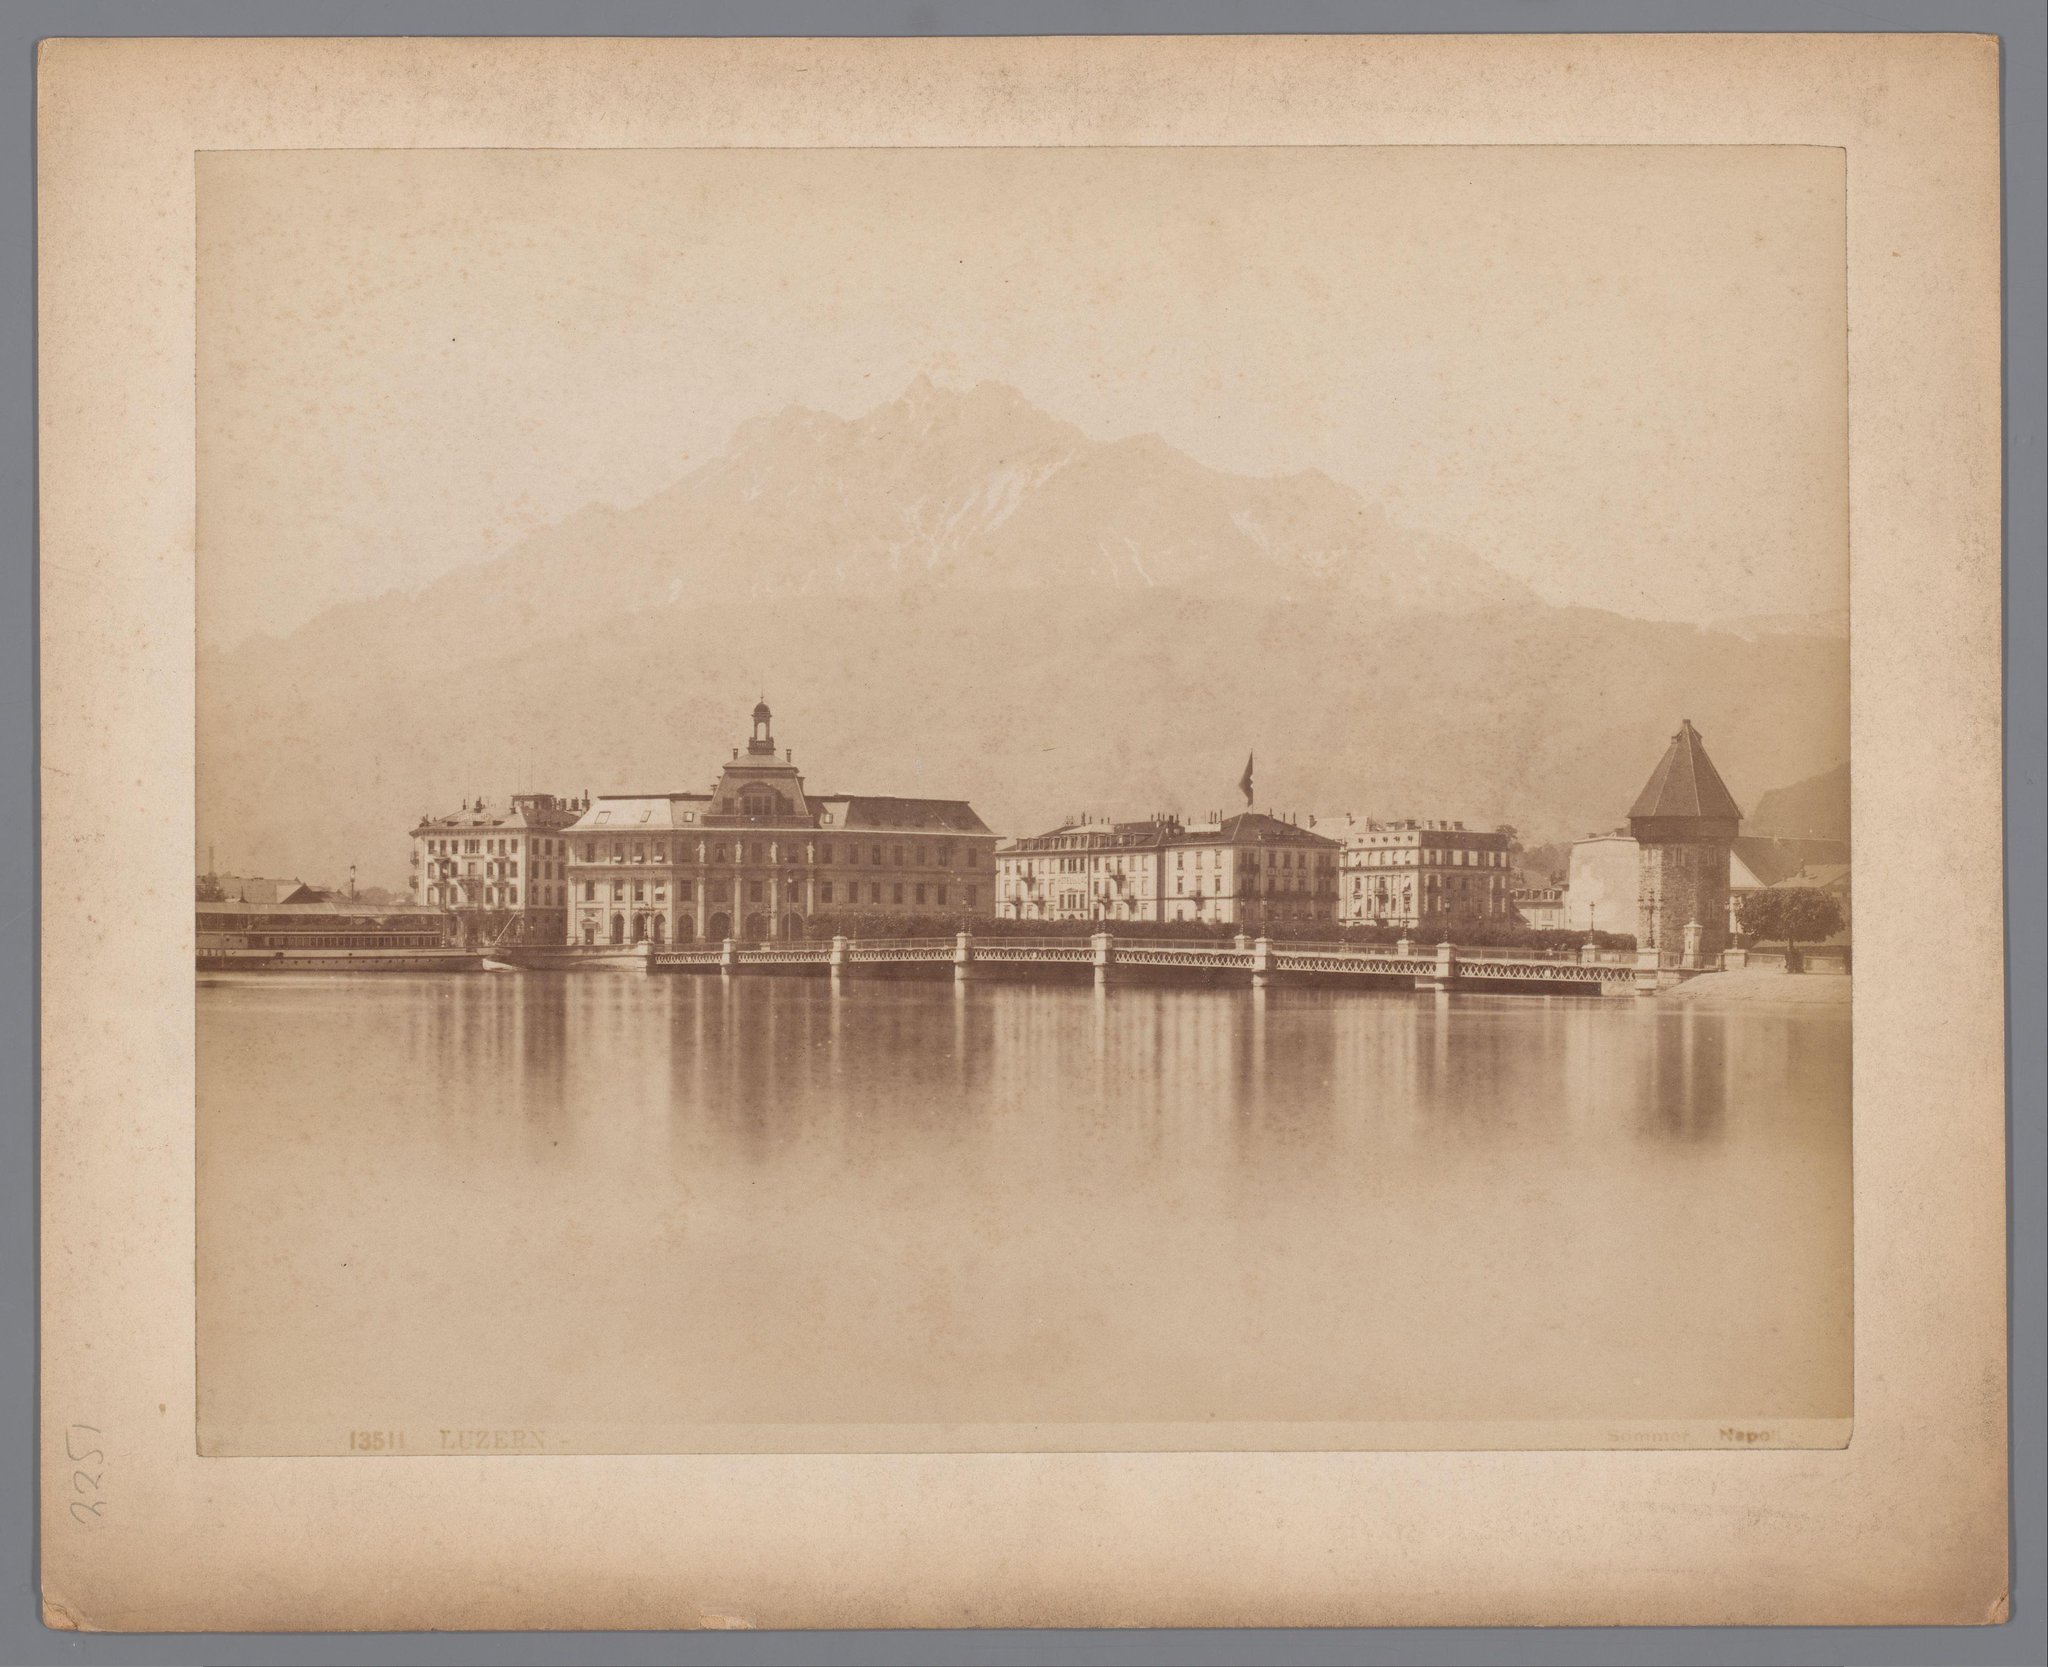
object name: photograph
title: Luzern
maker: giorgio sommer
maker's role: fotograaf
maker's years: 1834-1914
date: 1863-1914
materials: cardboard, paper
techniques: albumen print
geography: lucerne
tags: water tower, lake, bridge, mountains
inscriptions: number: ‘13511’, number: ‘2251’